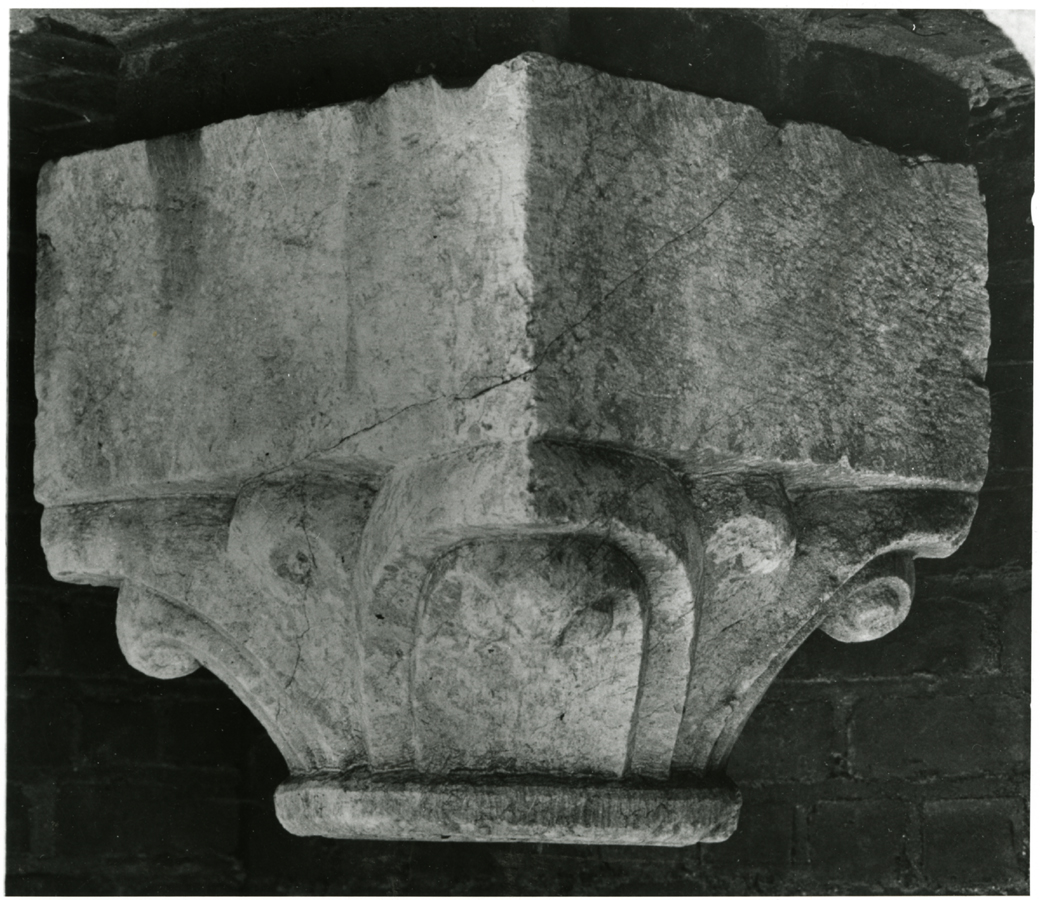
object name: capital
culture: catalan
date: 1130-1140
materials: marble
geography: france